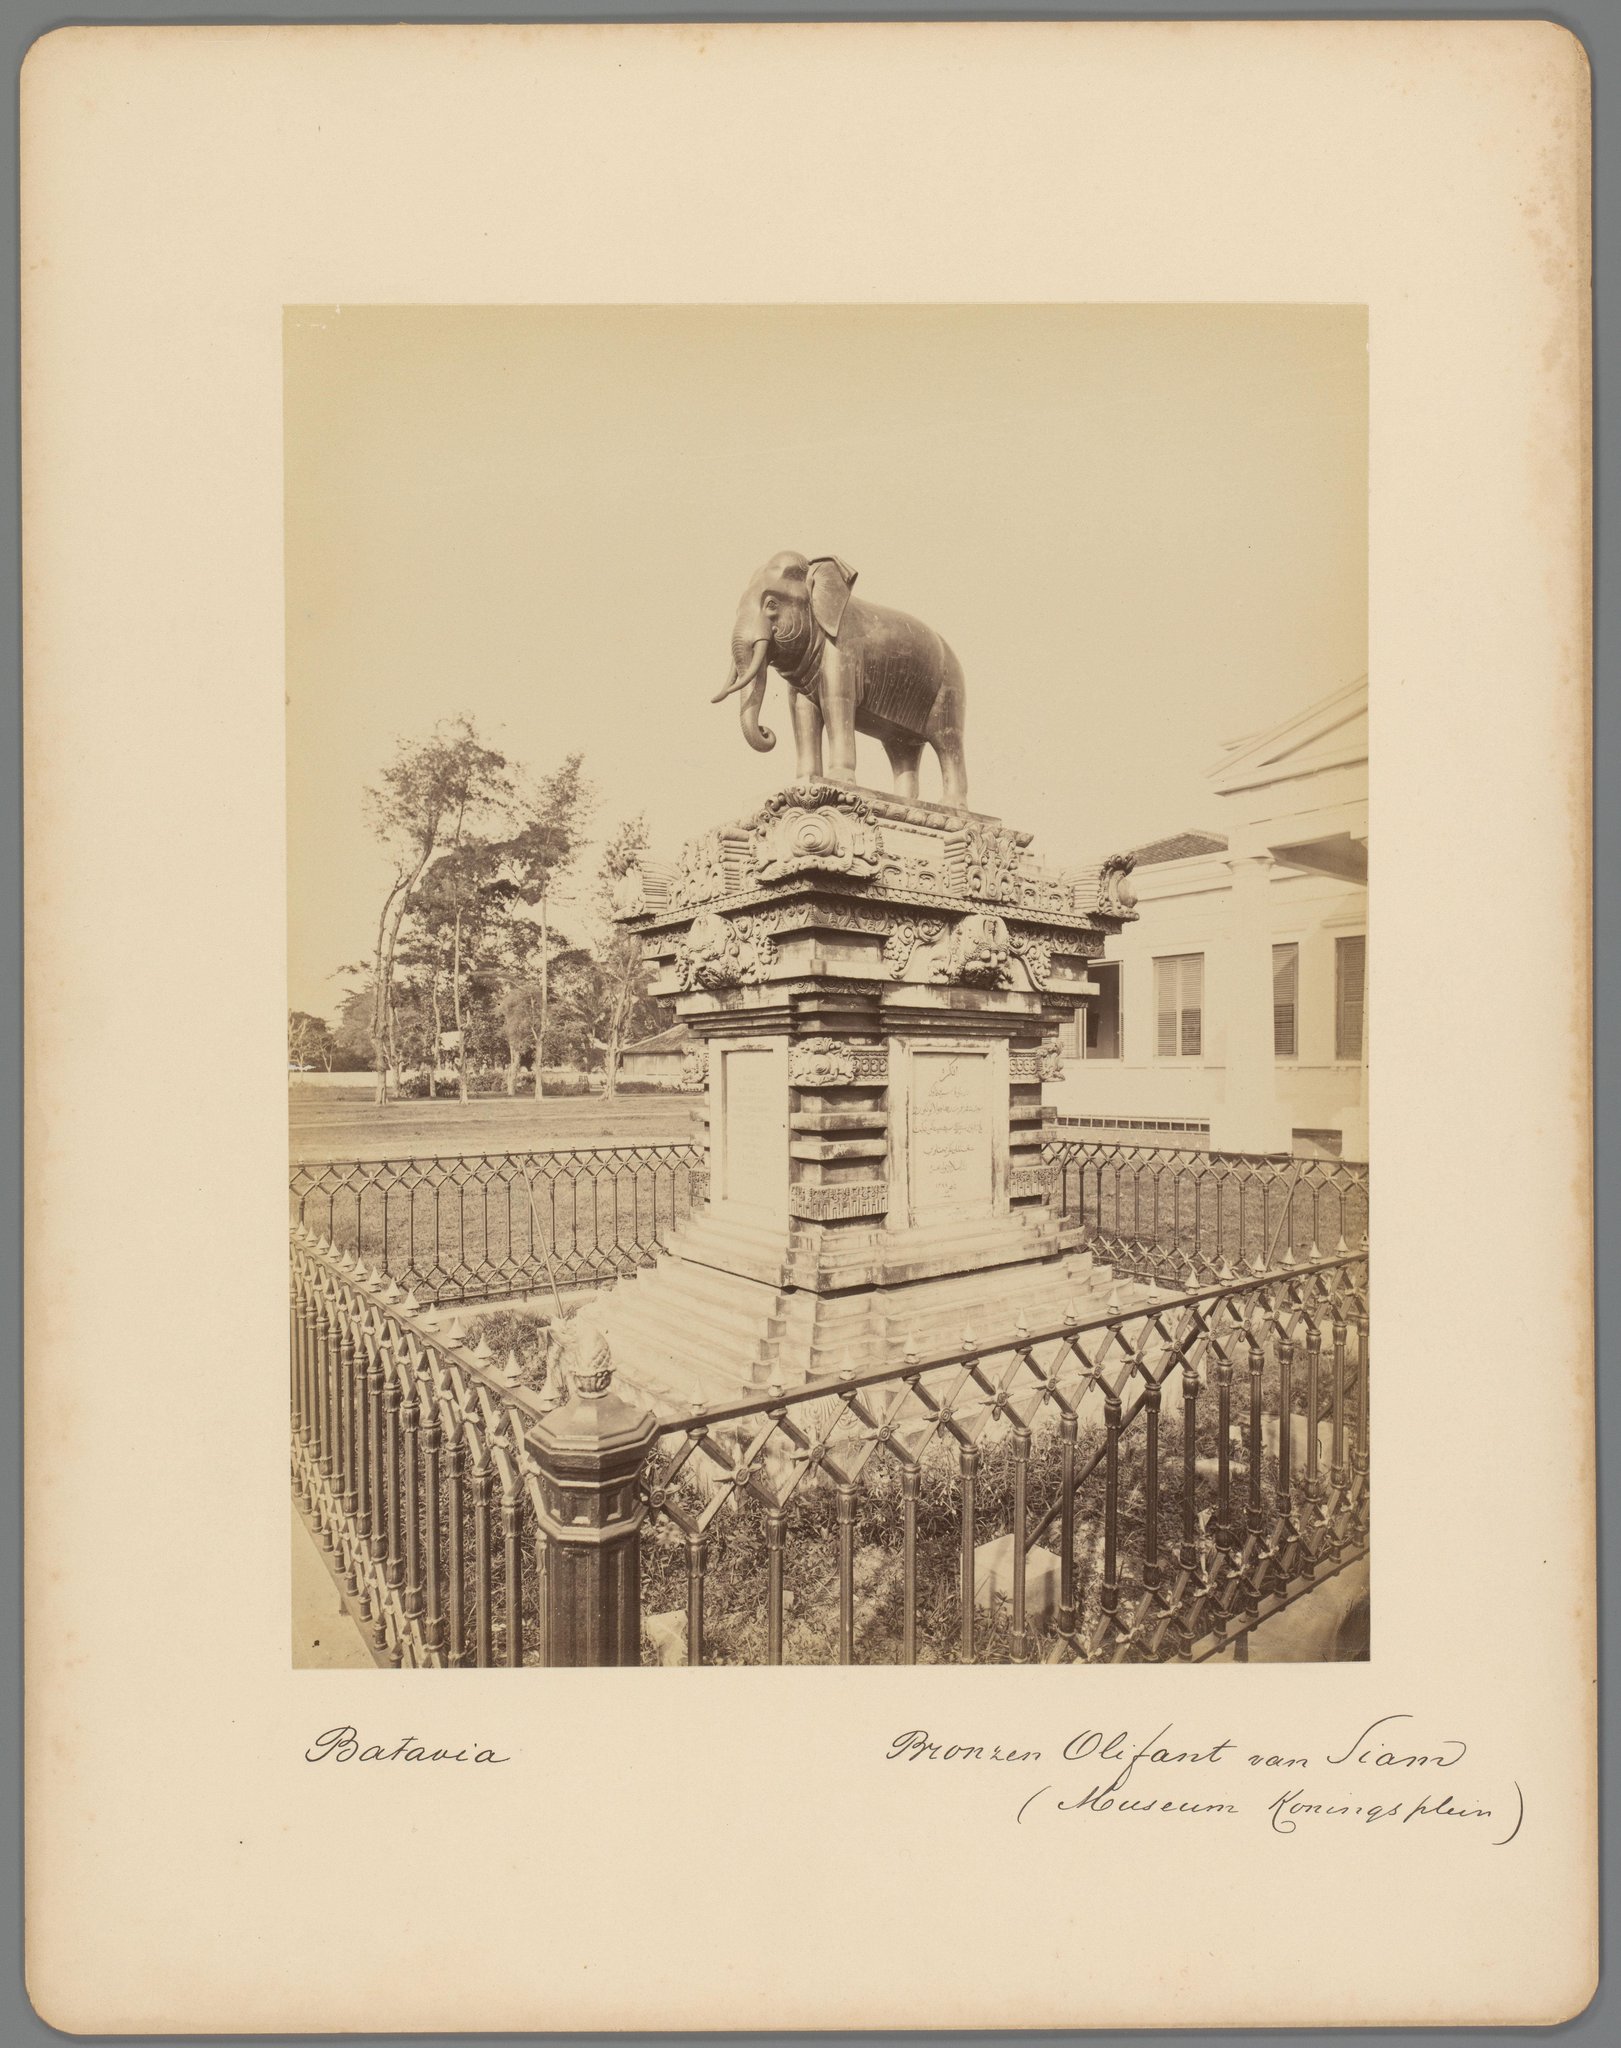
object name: photograph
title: Beeld van een olifant uit Thailand op het Koningsplein, Batavia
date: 1880-1895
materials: cardboard, paper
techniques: albumen print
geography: batavia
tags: piece of sculpture, reproduction of a piece of sculpture, trunked animals: elephant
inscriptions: check stamp: ‘Photographieen van Ned. Indië/ W & P/ Batavia’, inscription: ‘Foto’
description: Deze foto zat oorspronkelijk in prentenkabinet RP-F-AA3192.